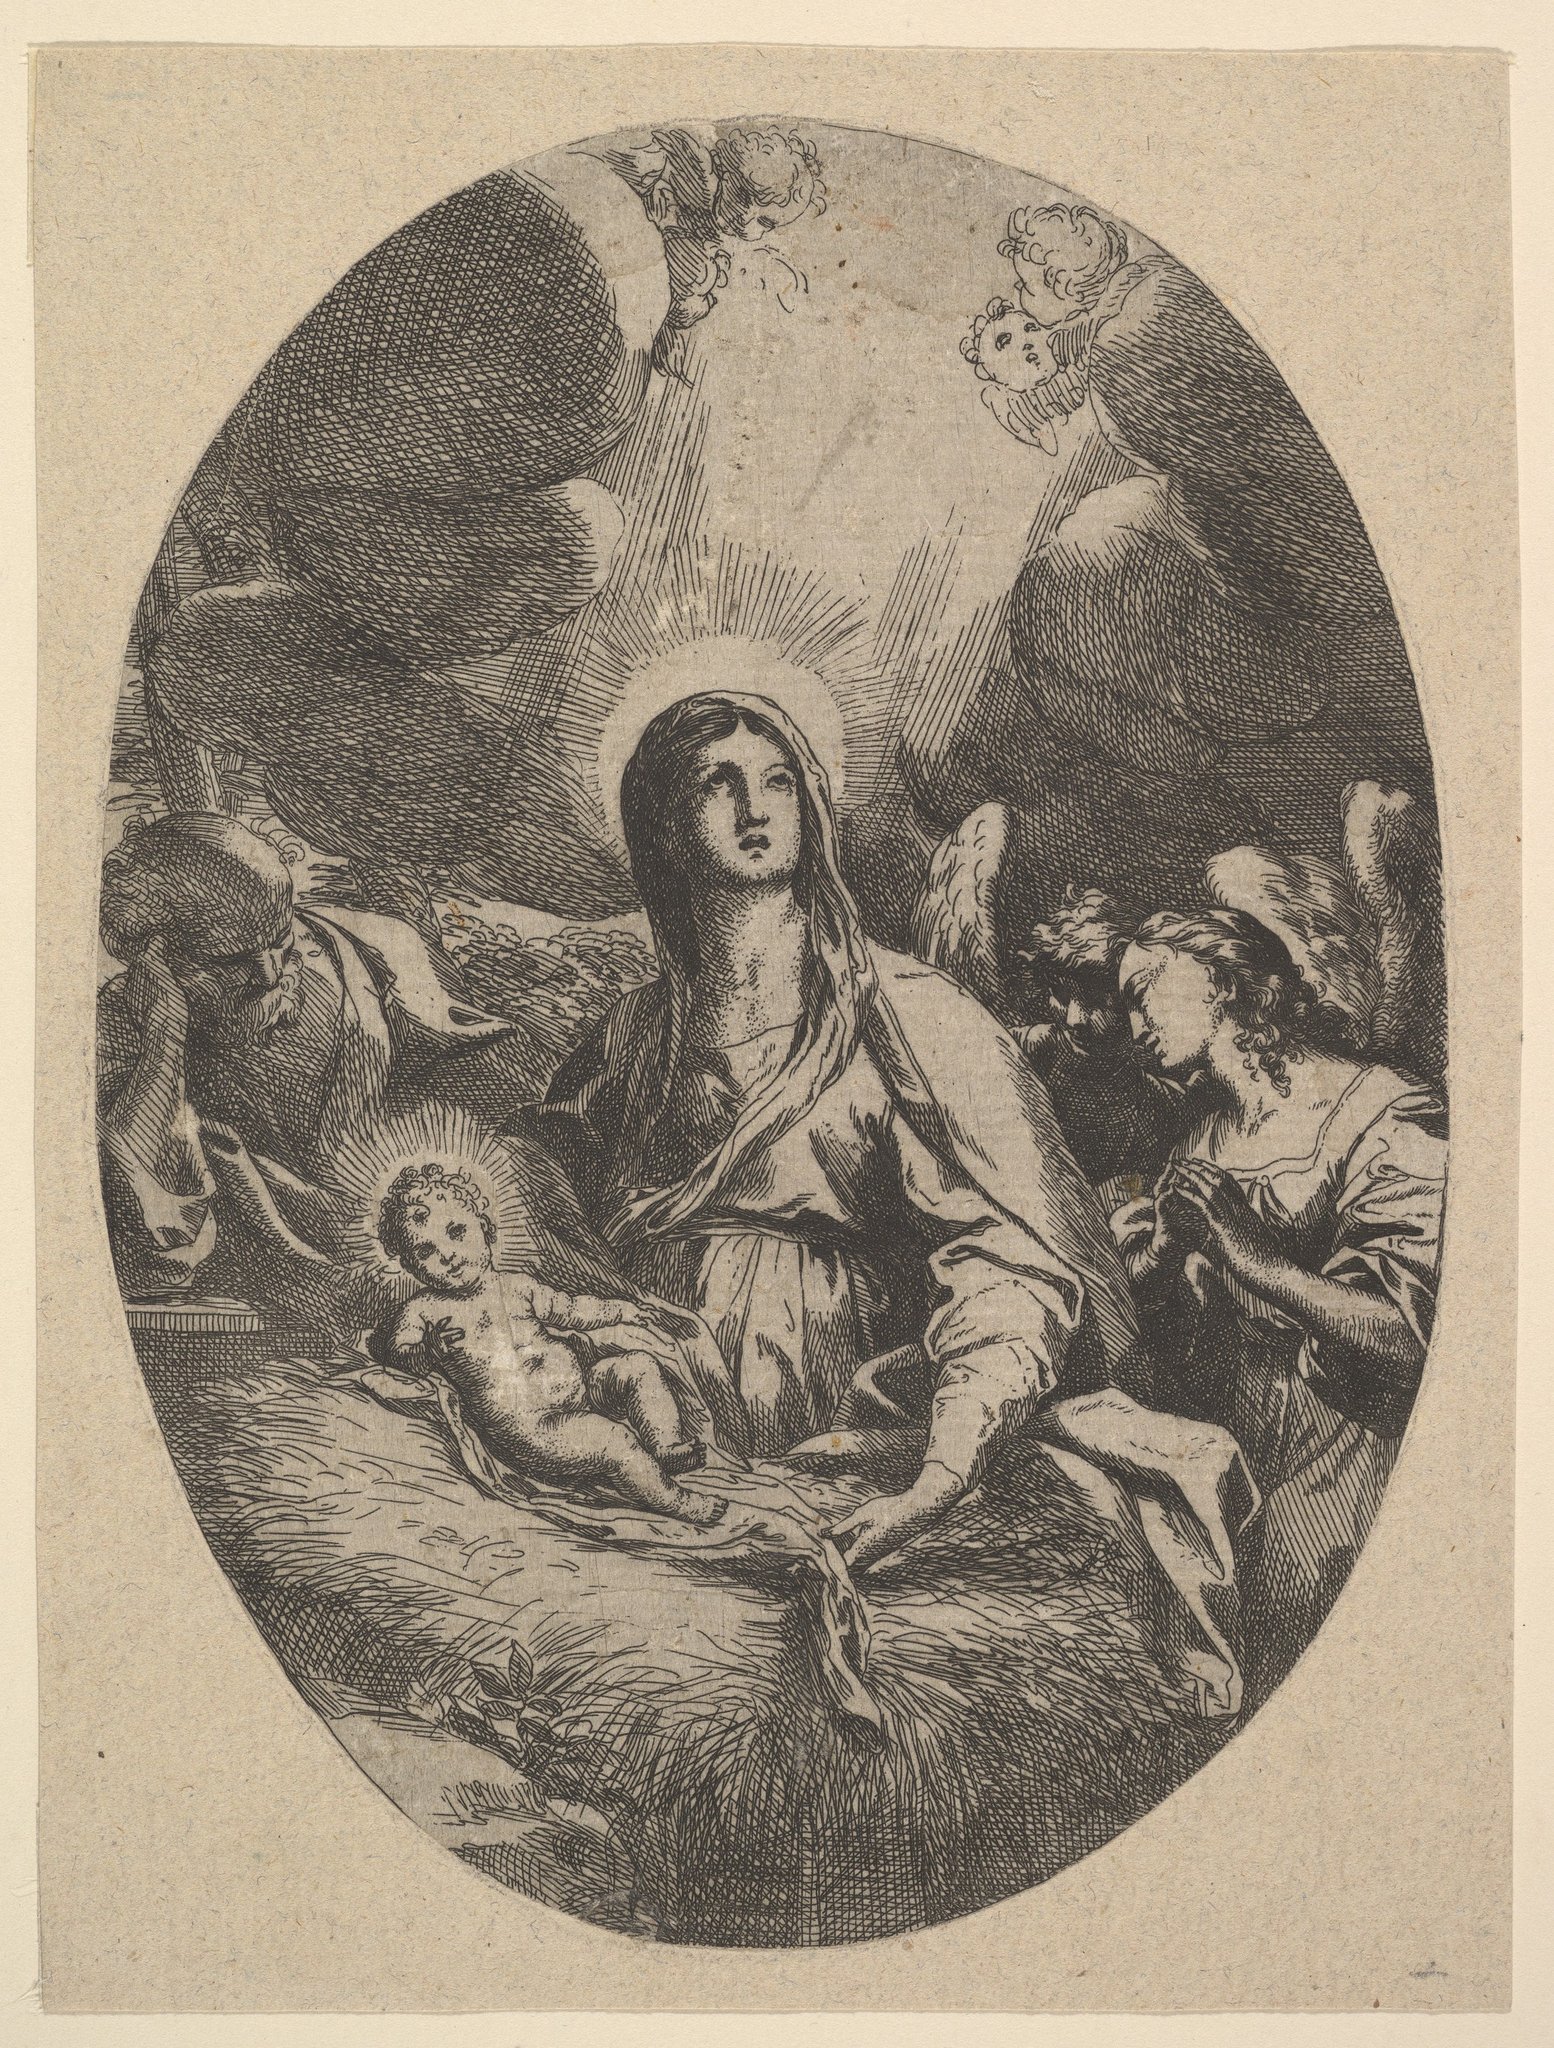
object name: print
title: The Adoration of the Angels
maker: carlo maratti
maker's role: artist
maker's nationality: italian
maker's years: 1625-1713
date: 1601-1700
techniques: etching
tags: men,angels,madonna and child